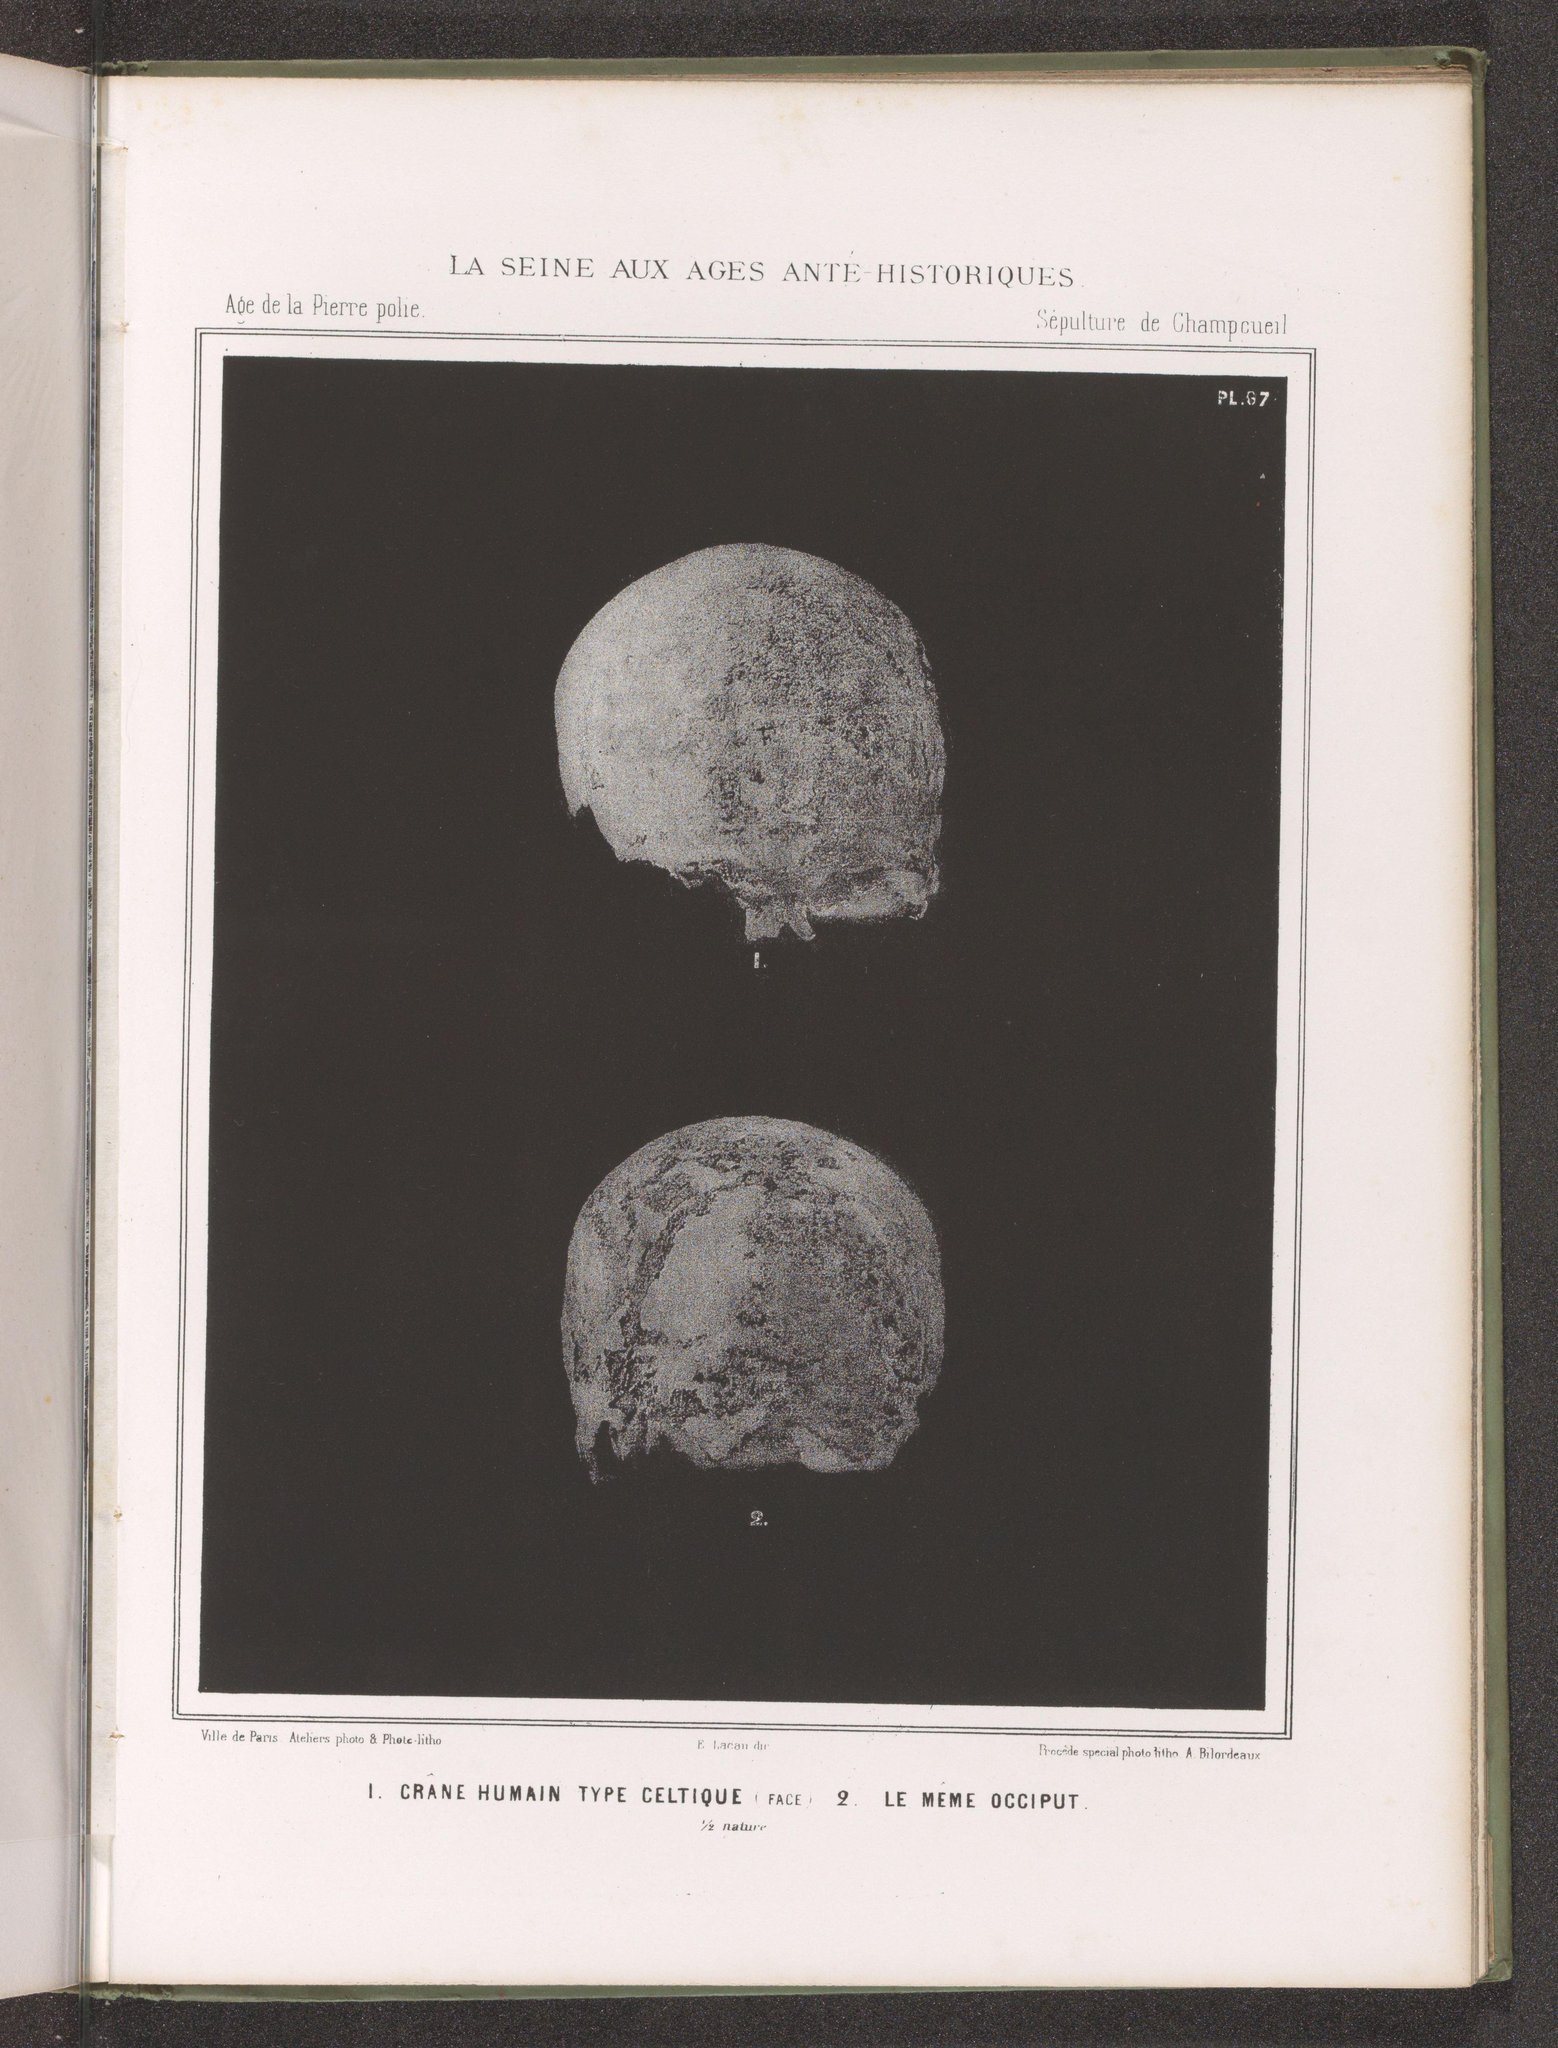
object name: page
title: 1. CRÂNE HUMAIN TYPE CELTIQUE (FACE) 2. LA MÊME OCCIPUT. 1/2 nature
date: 1860-1869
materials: paper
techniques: photolithography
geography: france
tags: animals (+ skeleton of an animal), palaeontology, france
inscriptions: inscription: ‘Ville de Paris Ateliers photo & Photo-litho E Lacan dir Procédé spécial photo-litho. A. Bilordeaux’, number: ‘Pl. 67’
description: Voor plek prent in boek: zie nummer onder 'Opschriften / Merken'.